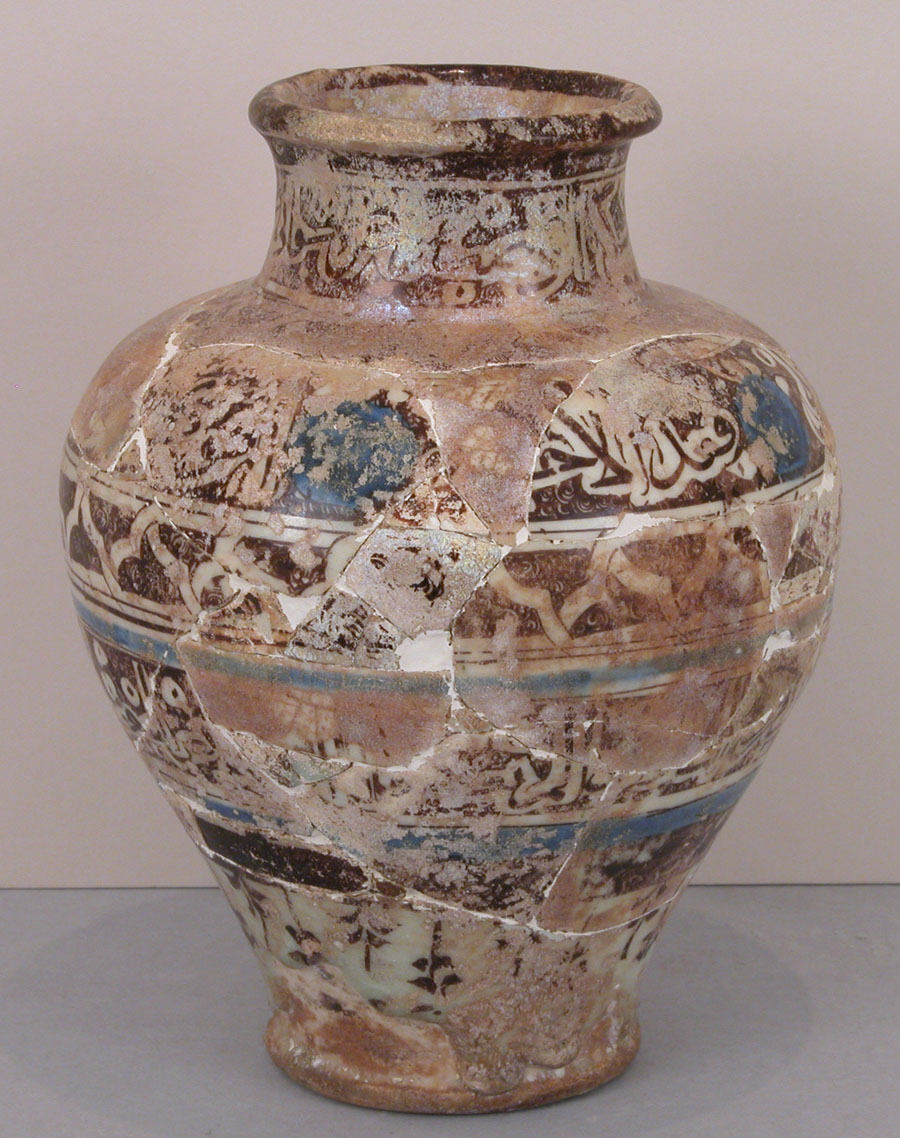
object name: jar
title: Jar with Three Inscribed Bands in Cursive Script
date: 1101-1200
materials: glaze, stonepaste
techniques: luster painting, underglaze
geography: syria